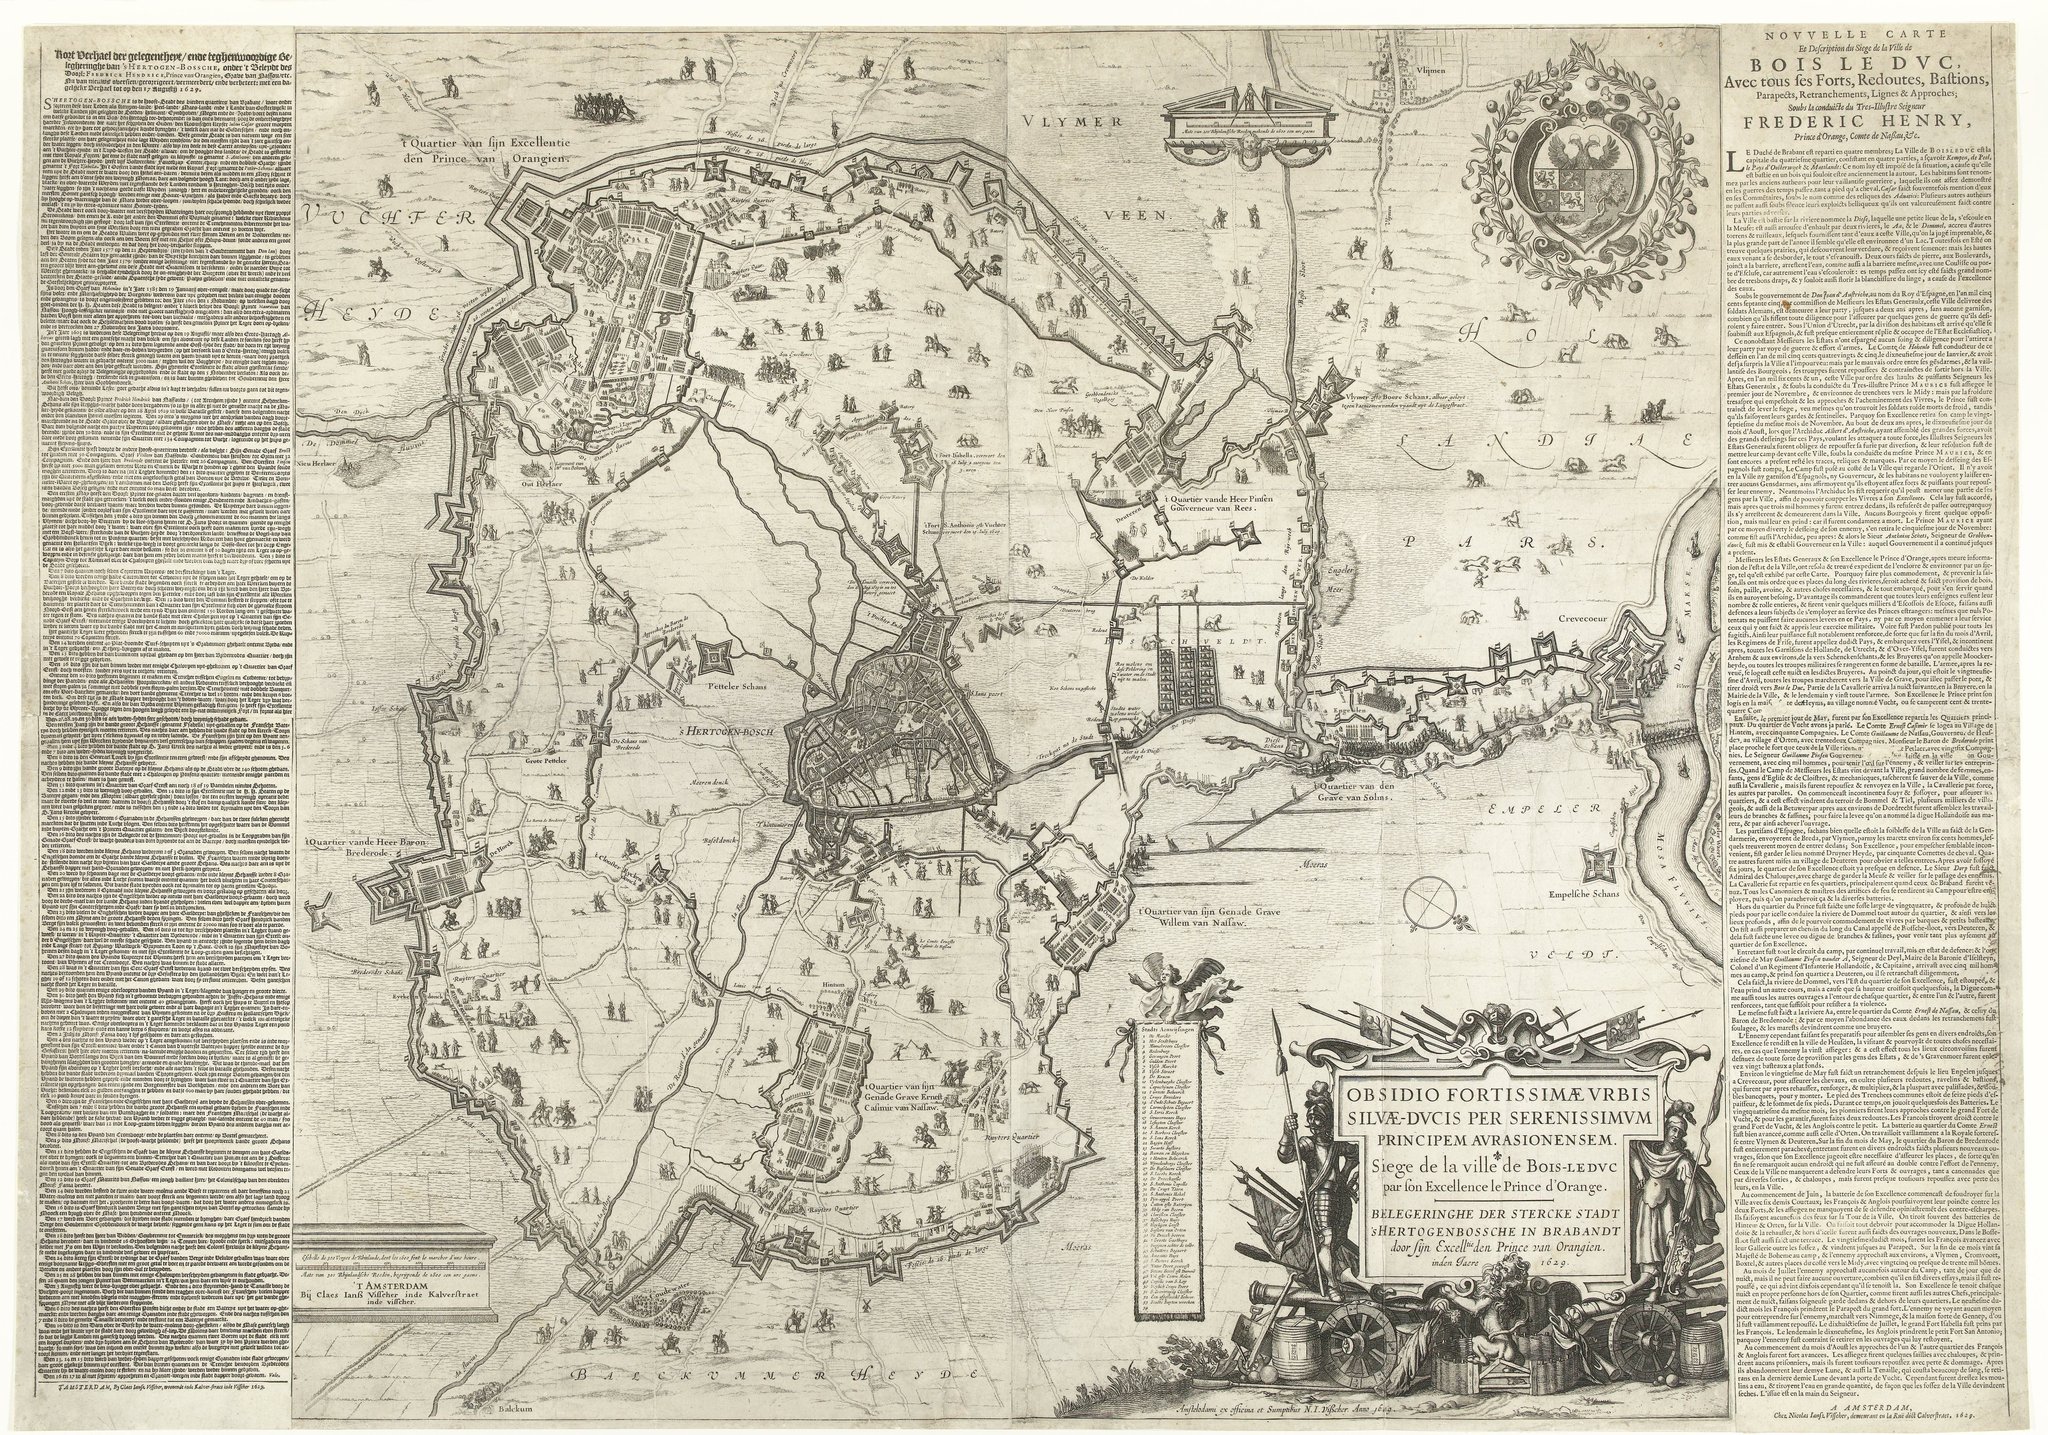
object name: print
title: Belegeringhe der stercke stadt sHertogenbossche in Brabandt door (...) den Prince van Orangien. inden Jaere 1629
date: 1629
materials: paper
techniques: engraving, etching, letterpress printing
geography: amsterdam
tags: frederick henry (prince of orange), maps of separate countries or regions, siege, position war, den bosch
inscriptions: date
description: Grote kaart van het beleg van Den Bosch door het Staatse leger onder Frederik Hendrik, van 1 mei tot 17 september 1629. Kaart met centraal de versterkte stad. Rechtsonder een cartouche versierd met een soldaat, Minerva, de Hollandse Tuin en wapentuig. Rechtsboven het wapen van 's-Hertogenbosch. Links en rechts aangeplakte teksten met de beschrijving van de gebeurtenissen in het Nederlands en Frans.